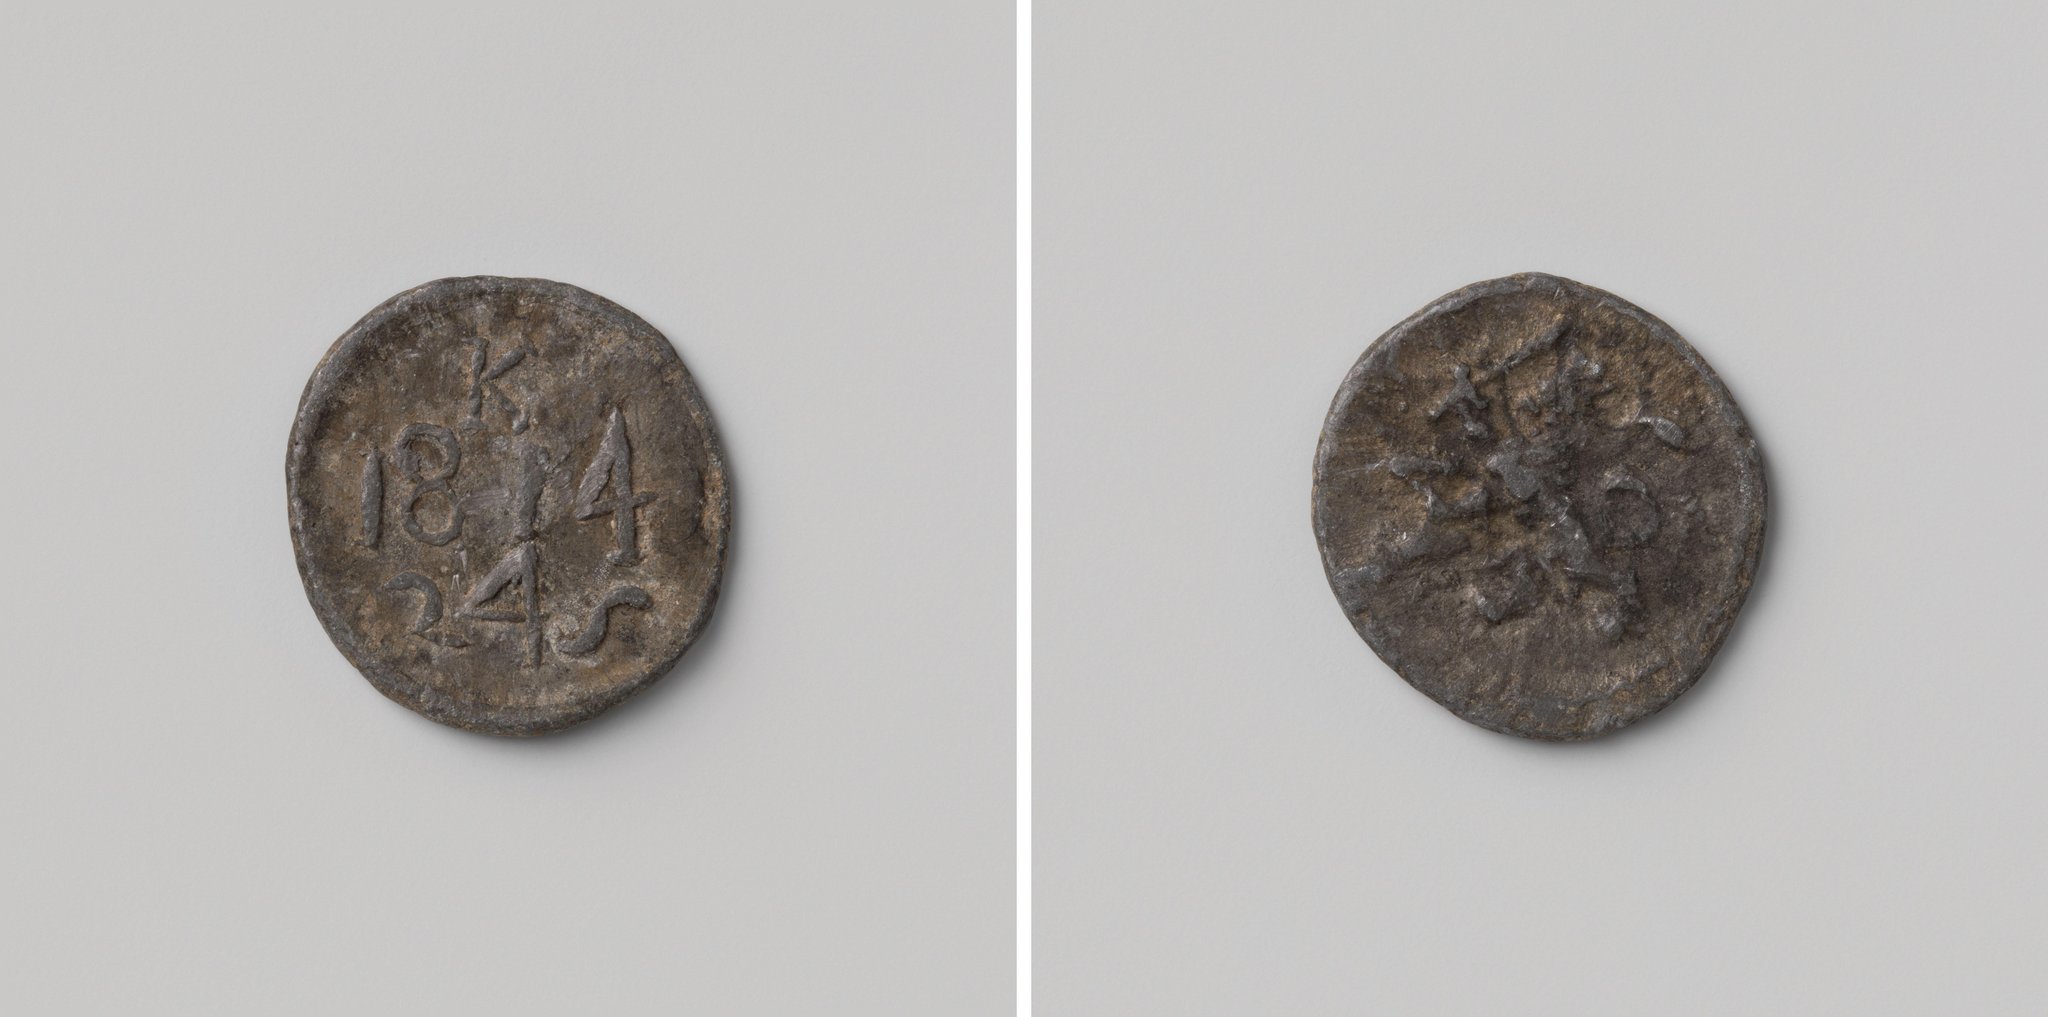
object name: tax token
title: Loden penning van de Kille (Dordtse Kil) met K 1814 24 S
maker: Anonymous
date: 1814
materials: lead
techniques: striking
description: Voorzijde: opschrift K 1814 24s. Keerzijde: gekroonde leeuw met zwaard en pijlenbundel